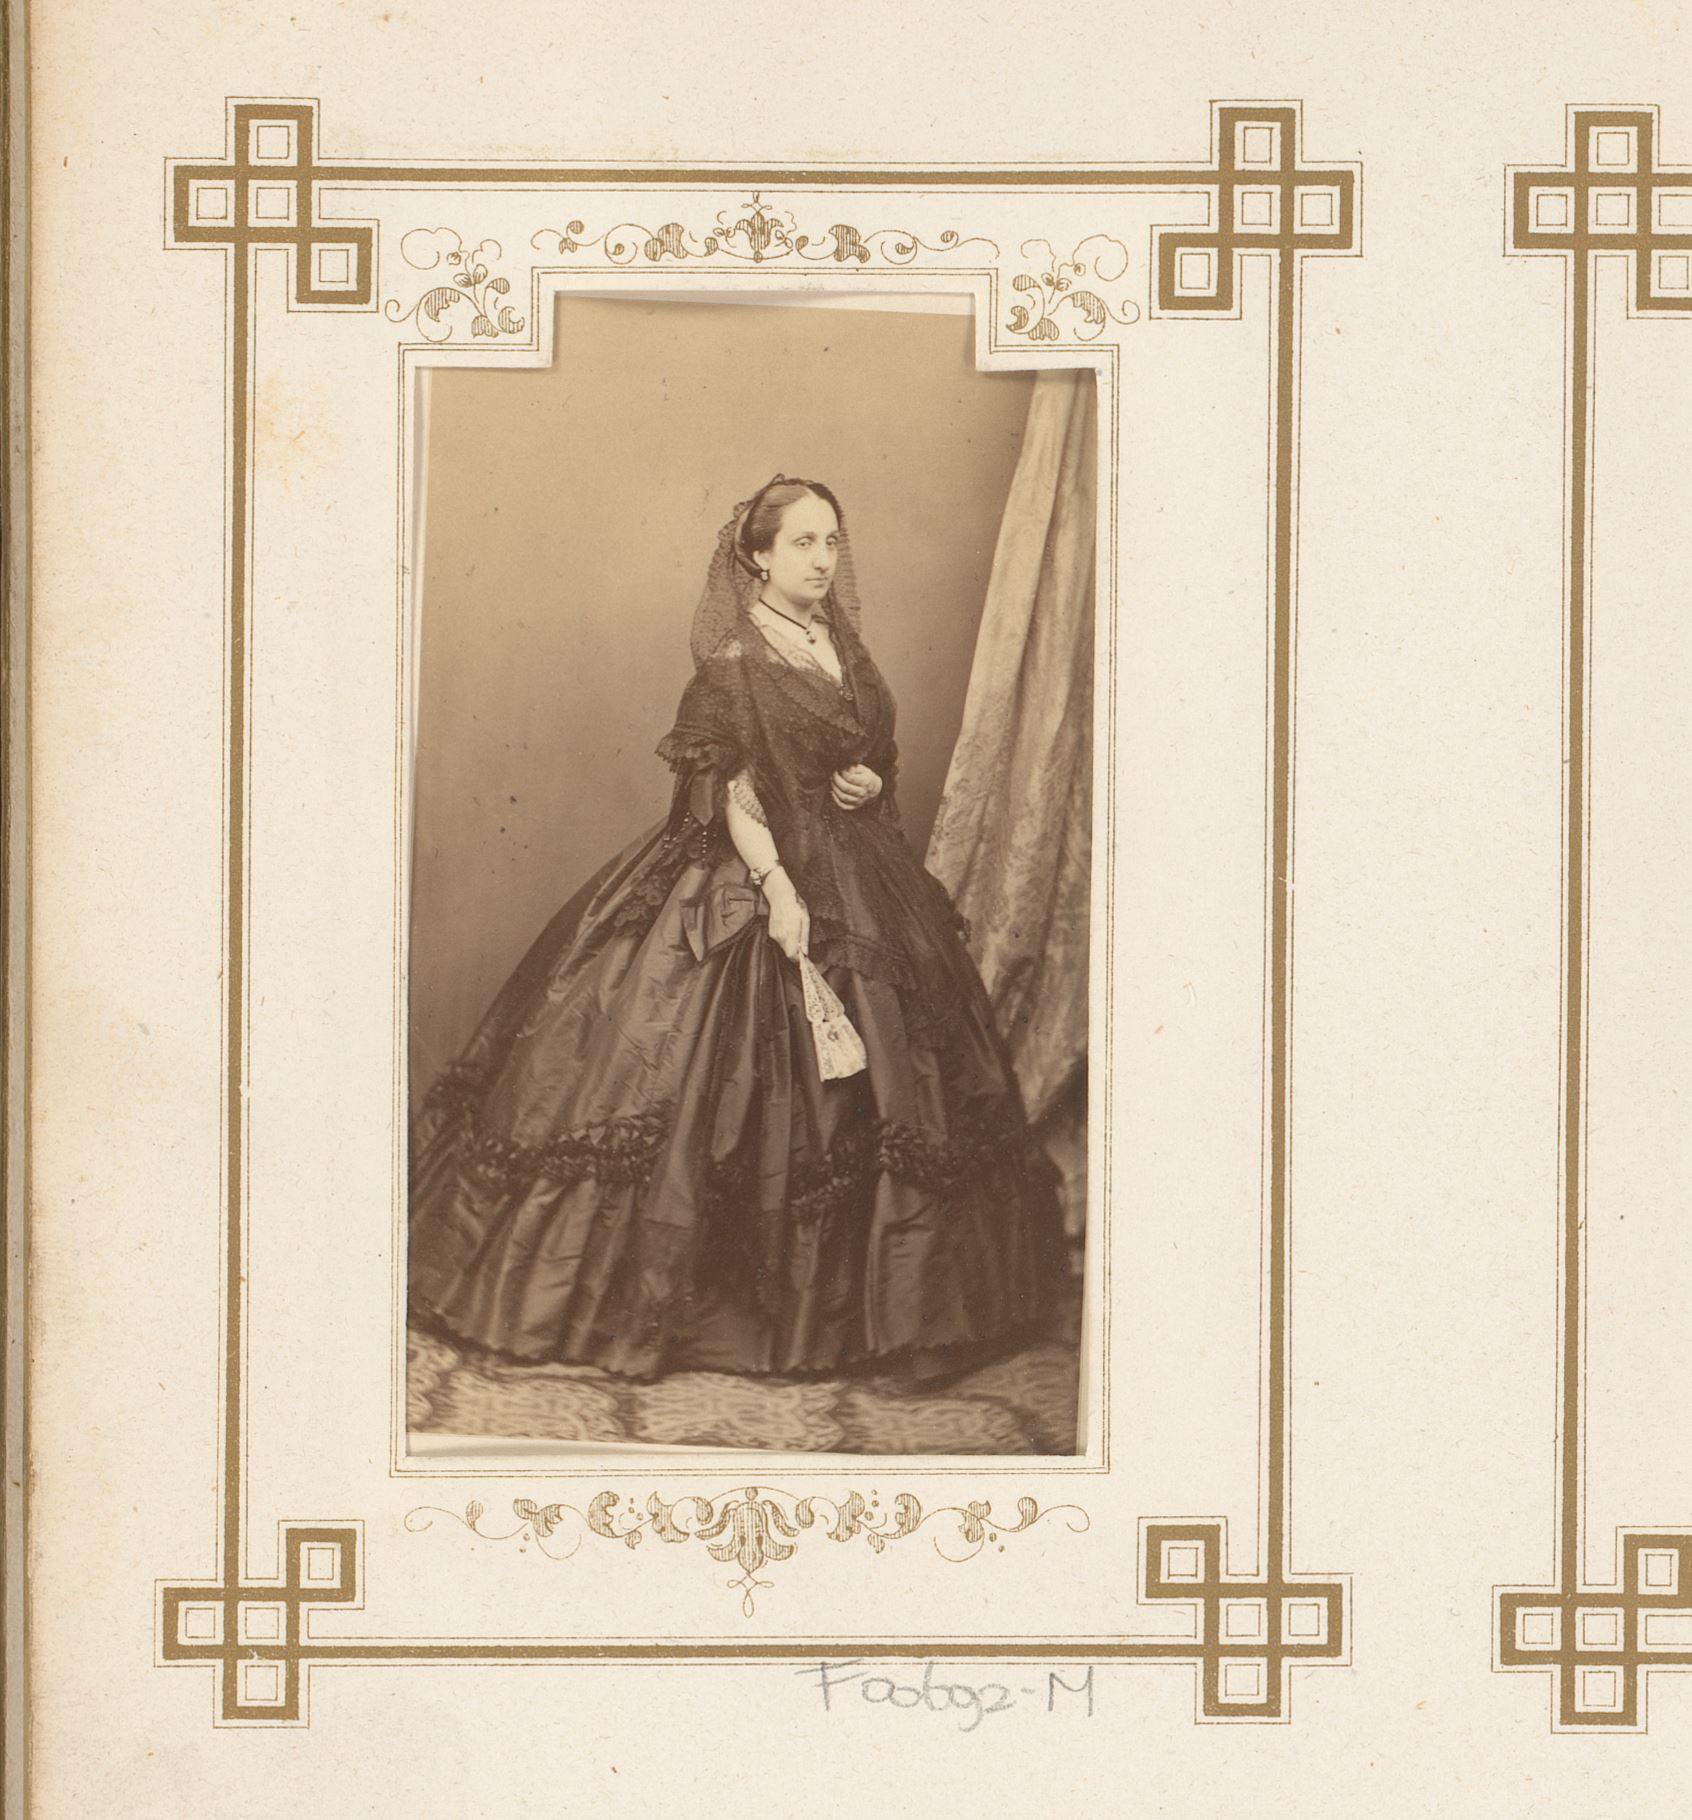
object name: photograph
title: Portret van een vrouw met waaier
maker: maurice hébert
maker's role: fotograaf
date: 1850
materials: cardboard, photographic support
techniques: albumen print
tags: historical persons - bb - woman, fan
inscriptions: inscription: ‘Caballero de Gracia 30 y 32, Galeria de Cristales’